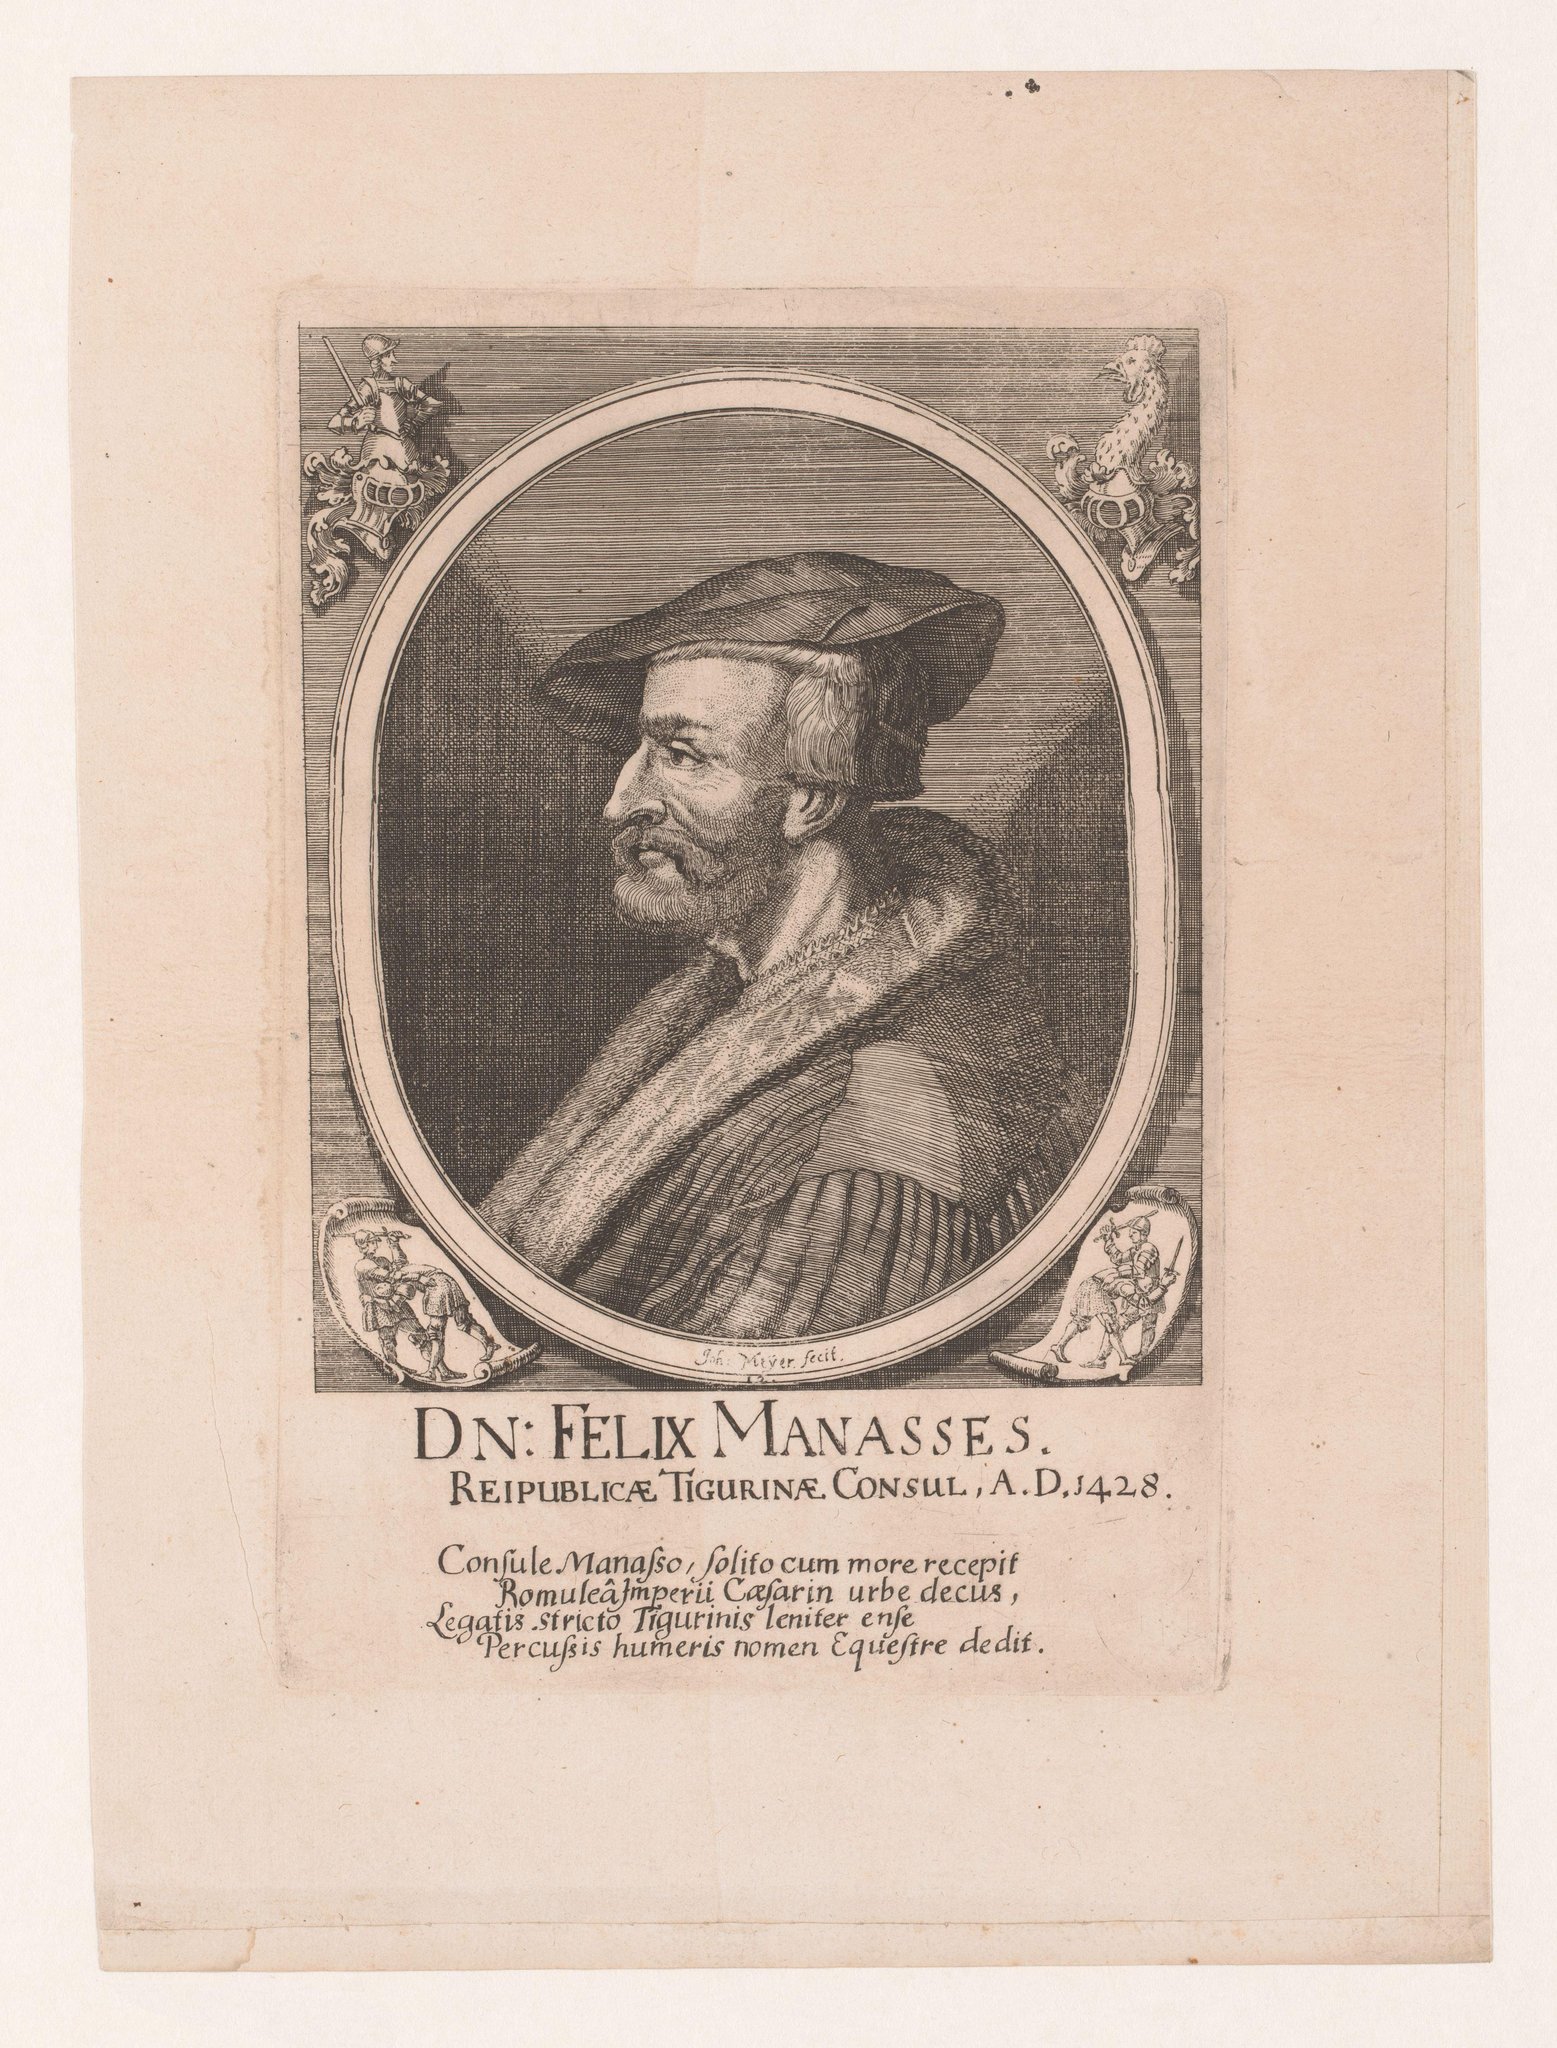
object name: print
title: Portretten van burgemeesters van Zürich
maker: johannes meyer (ii)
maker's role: print maker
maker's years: 1655-1712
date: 1665-1712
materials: paper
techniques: engraving, etching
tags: mayor, burgomaster, historical persons, armorial bearing, heraldry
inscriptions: collector's mark: Lugt 2228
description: Onderaan de ovale omlijsting genummerd: 12.